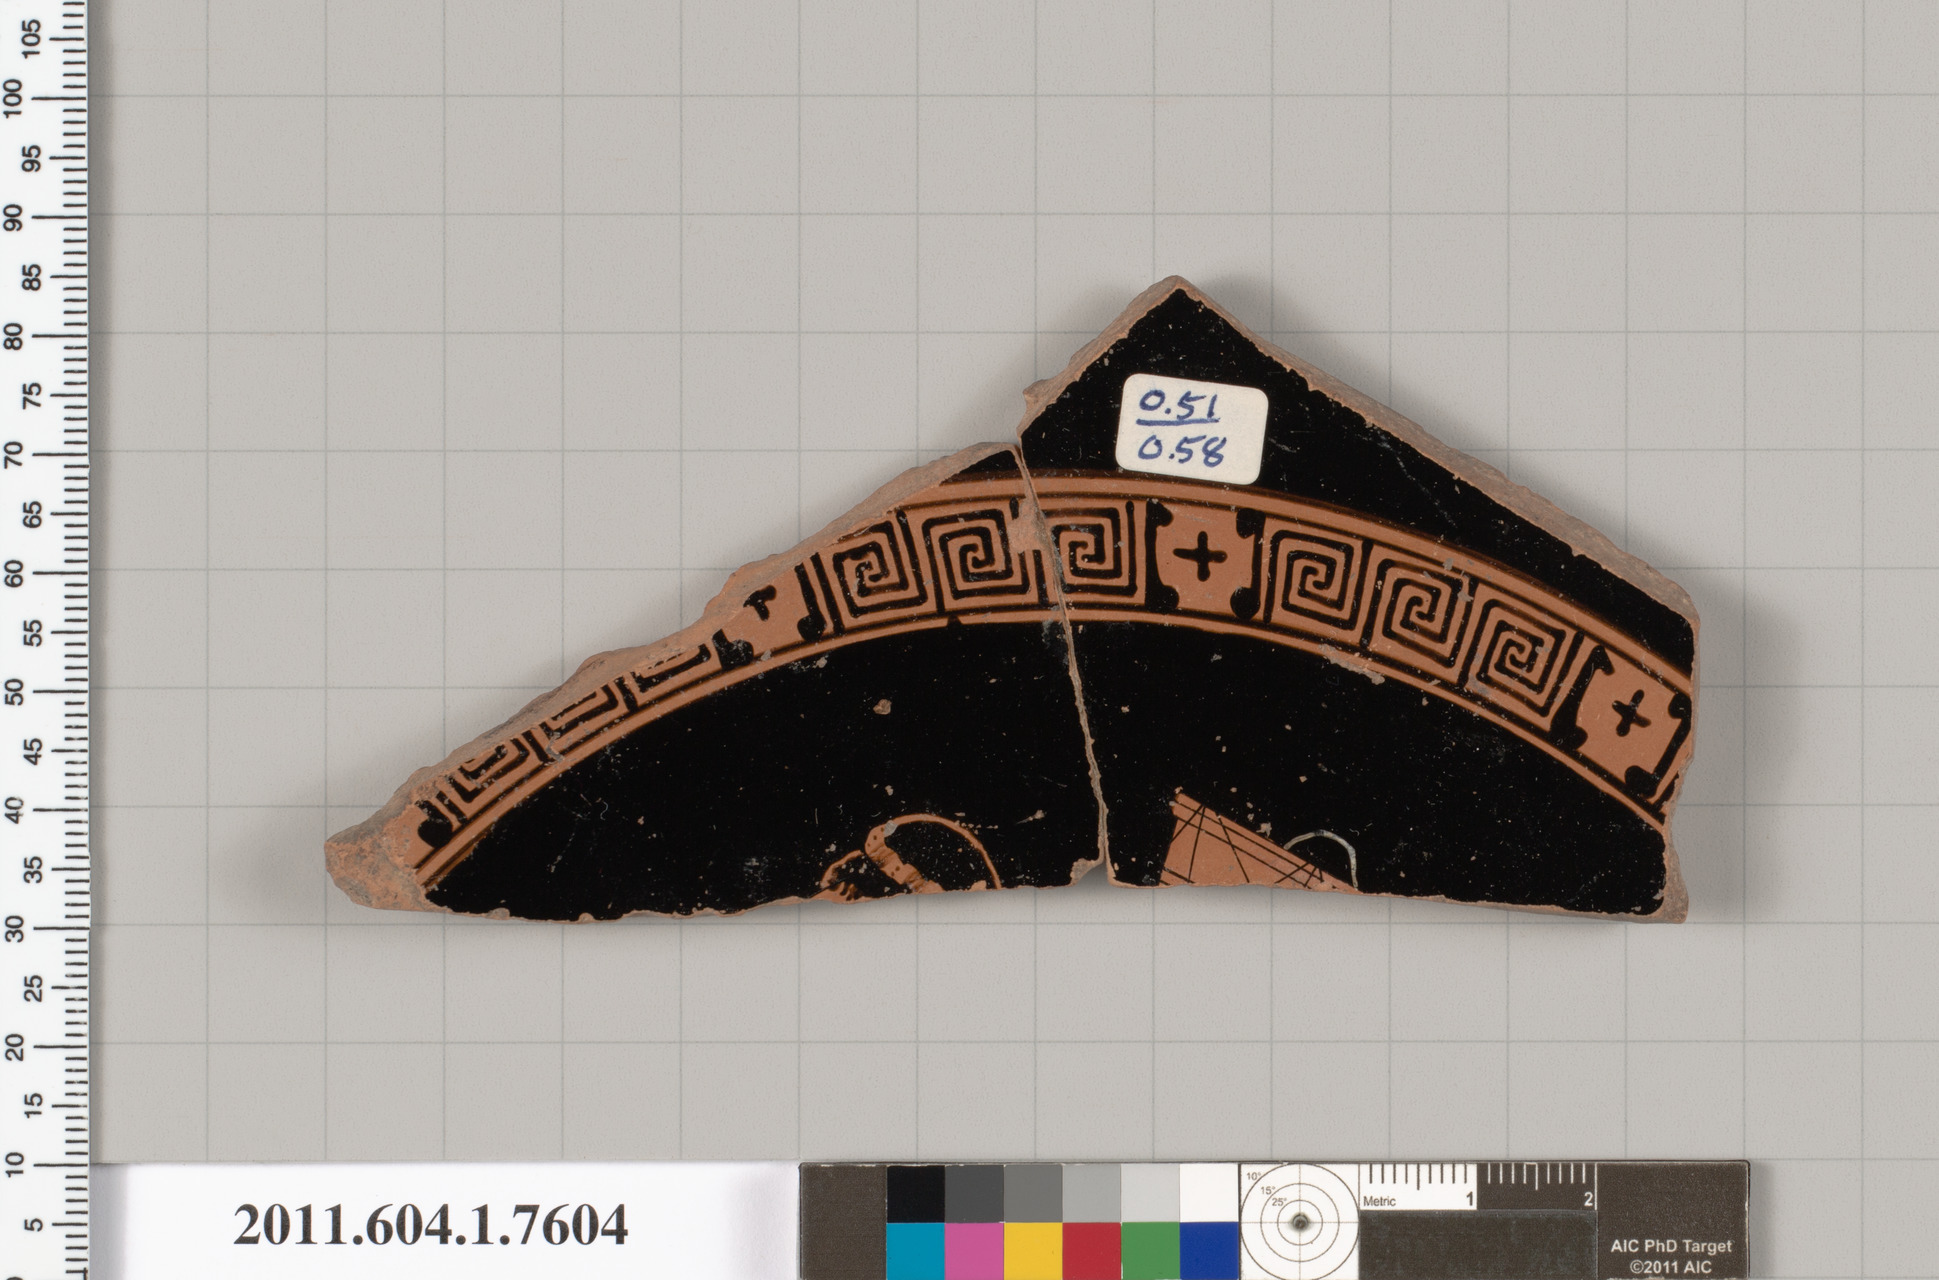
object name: kylix fragment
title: Terracotta fragment of a kylix (drinking cup)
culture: greek, attic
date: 460-450 BCE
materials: terracotta